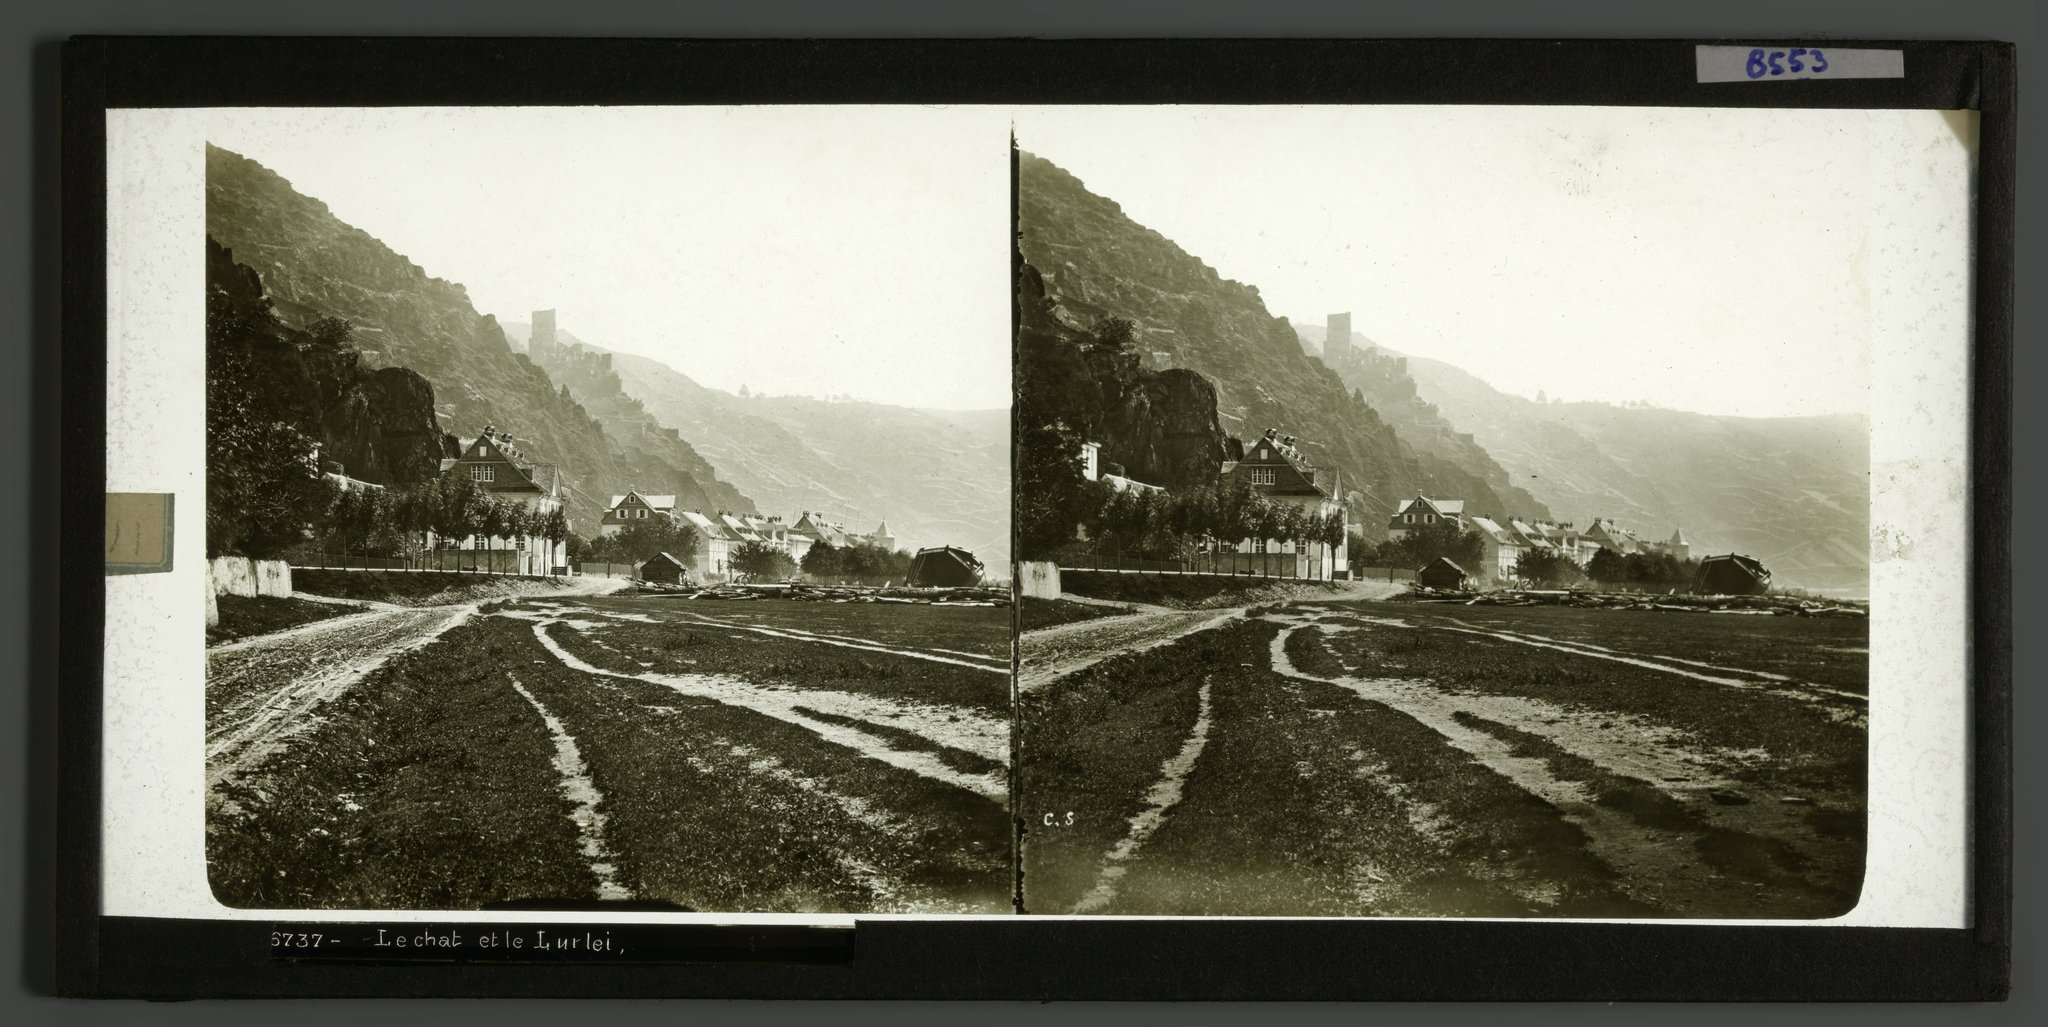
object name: stereoscopic photograph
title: Gezicht op de Loreley bij Sankt Goarshausen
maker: ferrier père-fils et soulier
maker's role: publisher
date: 1860-1890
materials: cardboard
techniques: slide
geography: sankt goarshausen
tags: mountains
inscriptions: number: ‘6737’